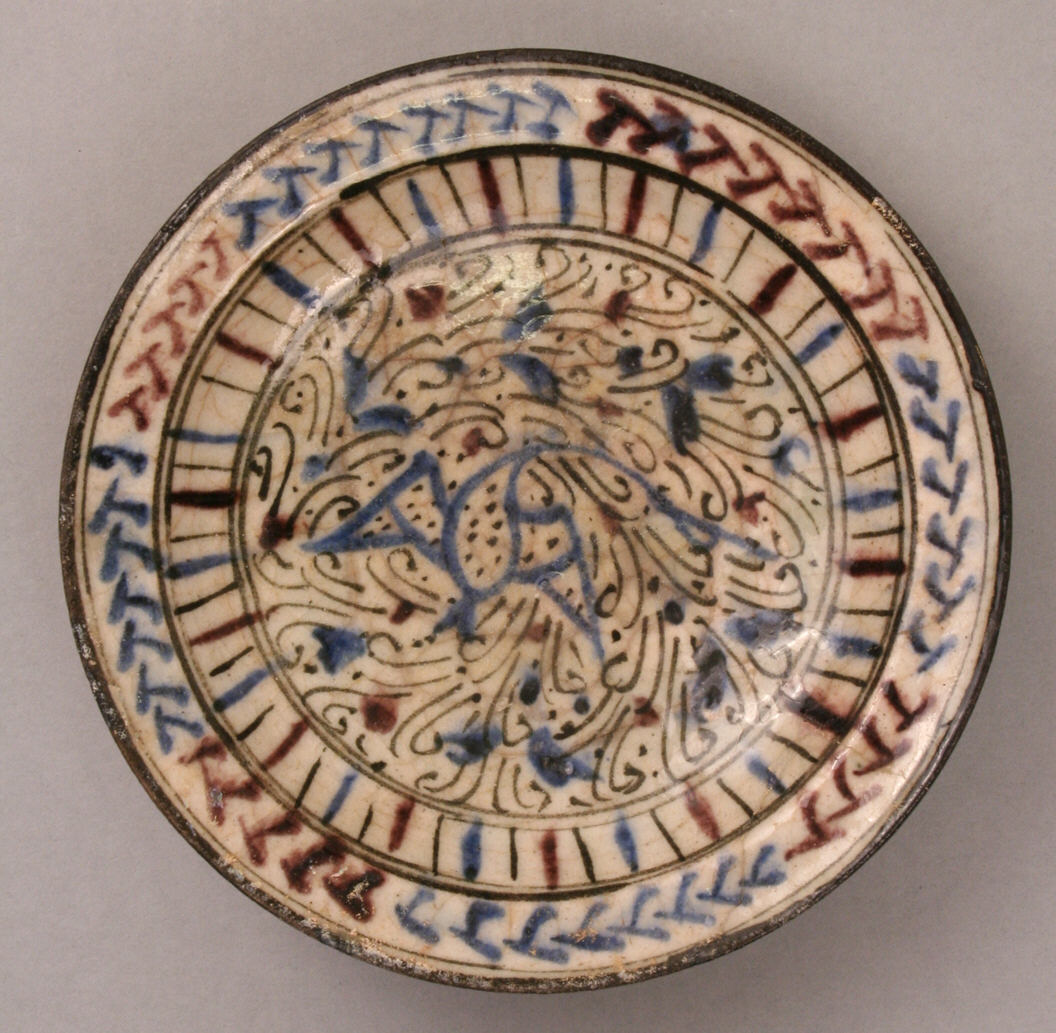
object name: dish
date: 1301-1400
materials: earthenware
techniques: glazing, painting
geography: iran